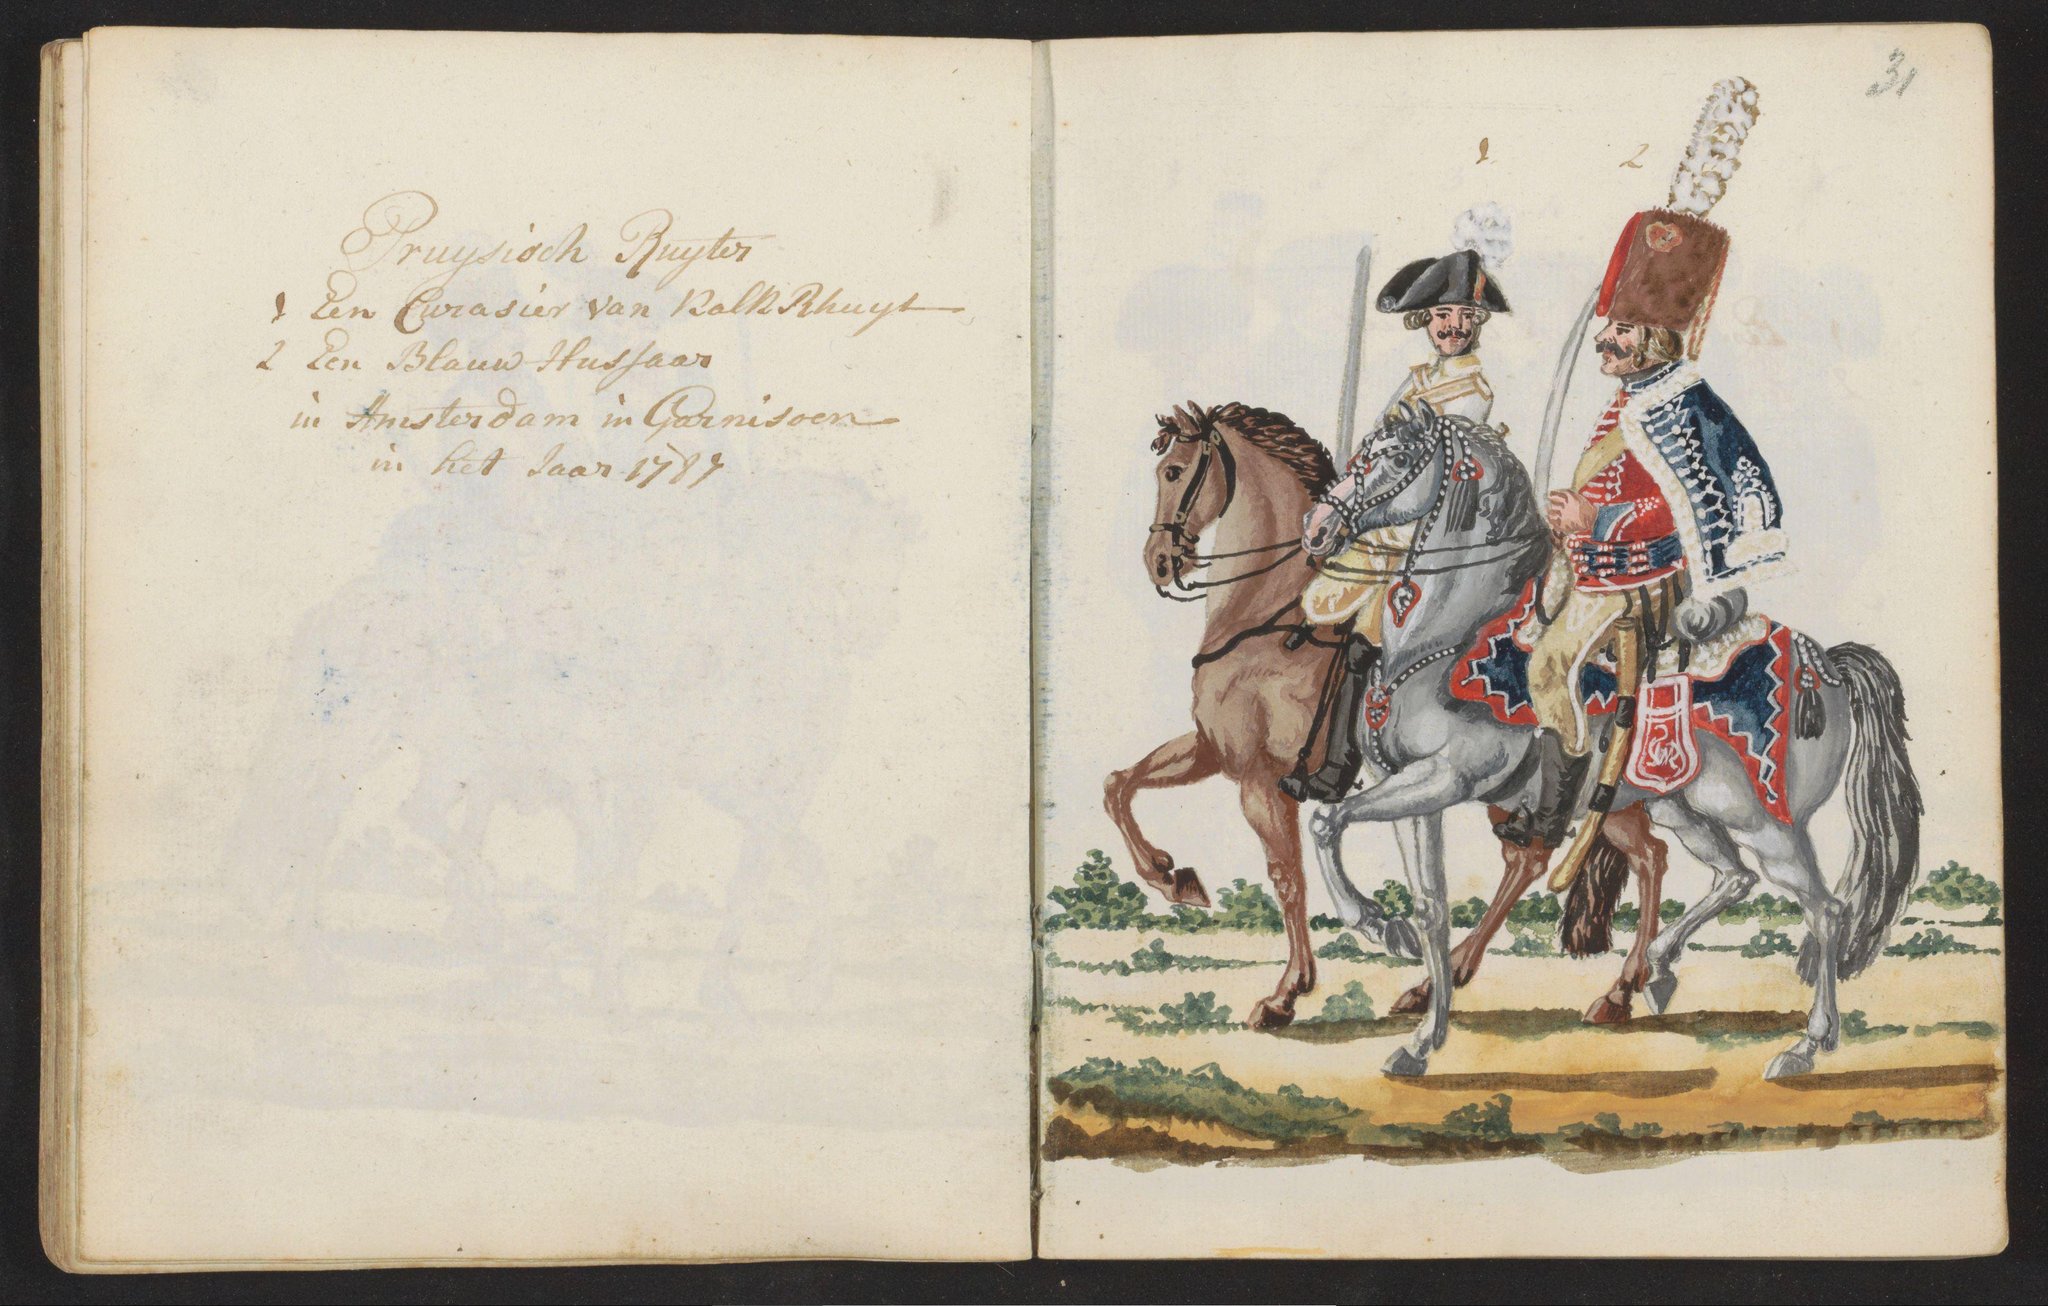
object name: drawing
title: Pruijsisch Ruyter (...) in Amsterdam in Garnisoen in het jaar 1787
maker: s.g. casten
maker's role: draughtsman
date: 1795-1796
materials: paper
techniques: writing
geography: amsterdam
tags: (military) uniforms (+ cavalry, horsemen), patriots (1780-1795)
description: De uniformen van twee Pruisische ruiters te Amsterdam in 1787. Onderdeel van het derde hoofdstuk over de nieuwe uniformen in de periode na het herstel van de prins van Oranje en de komst van de Pruisische troepen in Holland in 1787. In het schetsboek met gekleurde tekeningen van de uniformen van militairen en leden van de schutterij uit de periode 1770 tot 1795-1796.